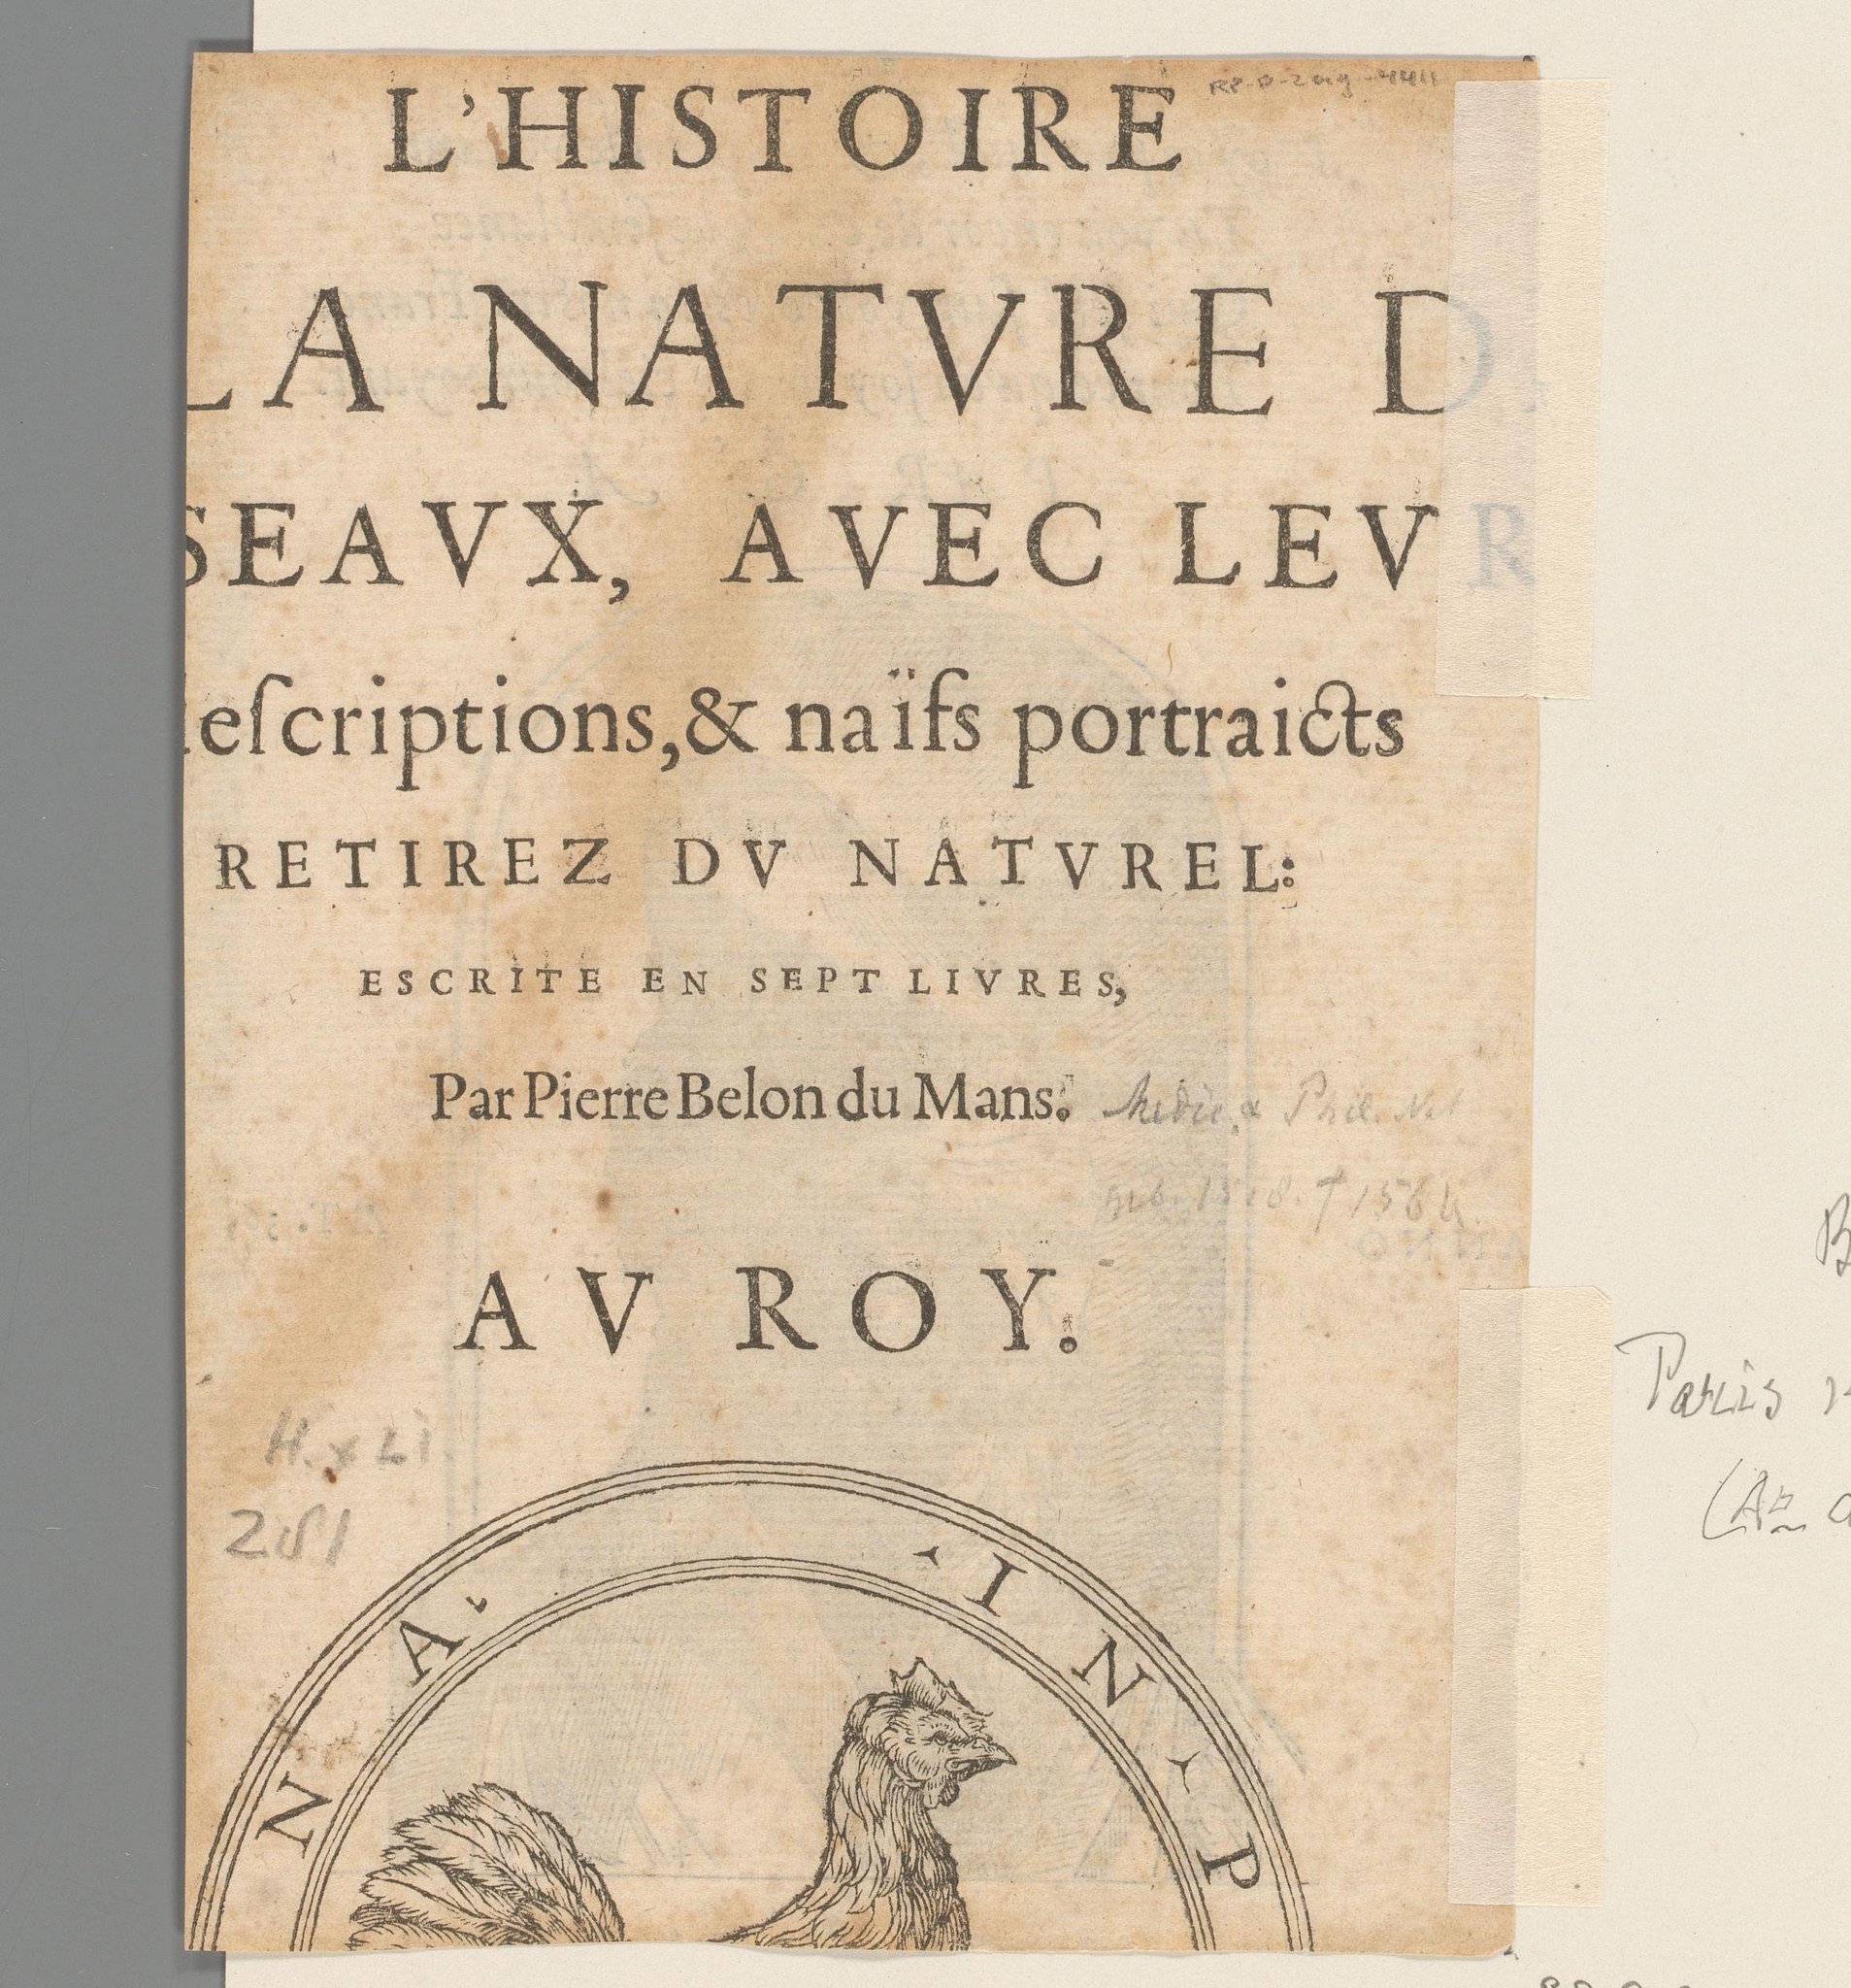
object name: titelblad, titelpagina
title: Titelpagina voor: Pierre Belon, L'histoire de la nature des oyseaux, 1555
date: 1555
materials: paper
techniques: letterpress printing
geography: paris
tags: fowl (cock, hen, chicken, etc.)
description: Prent uit: Belon, Pierre. L'histoire de la nature des oyseaux, avec leurs descriptions, & naïfs portraicts retirez du naturel (...). Parijs: Guillaume Cavellat, 1555.